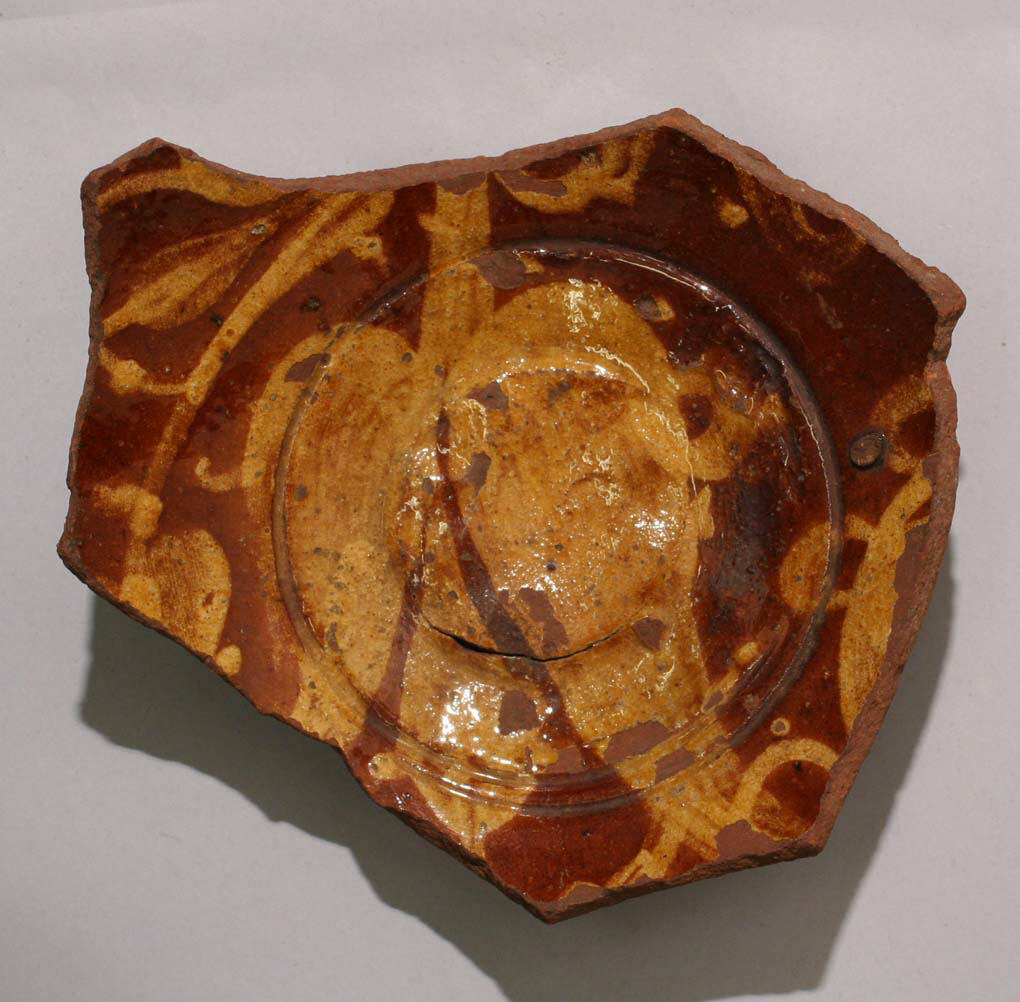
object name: fragment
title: Fragment of a Bowl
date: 1301-1500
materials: earthenware, glaze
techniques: painting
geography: egypt